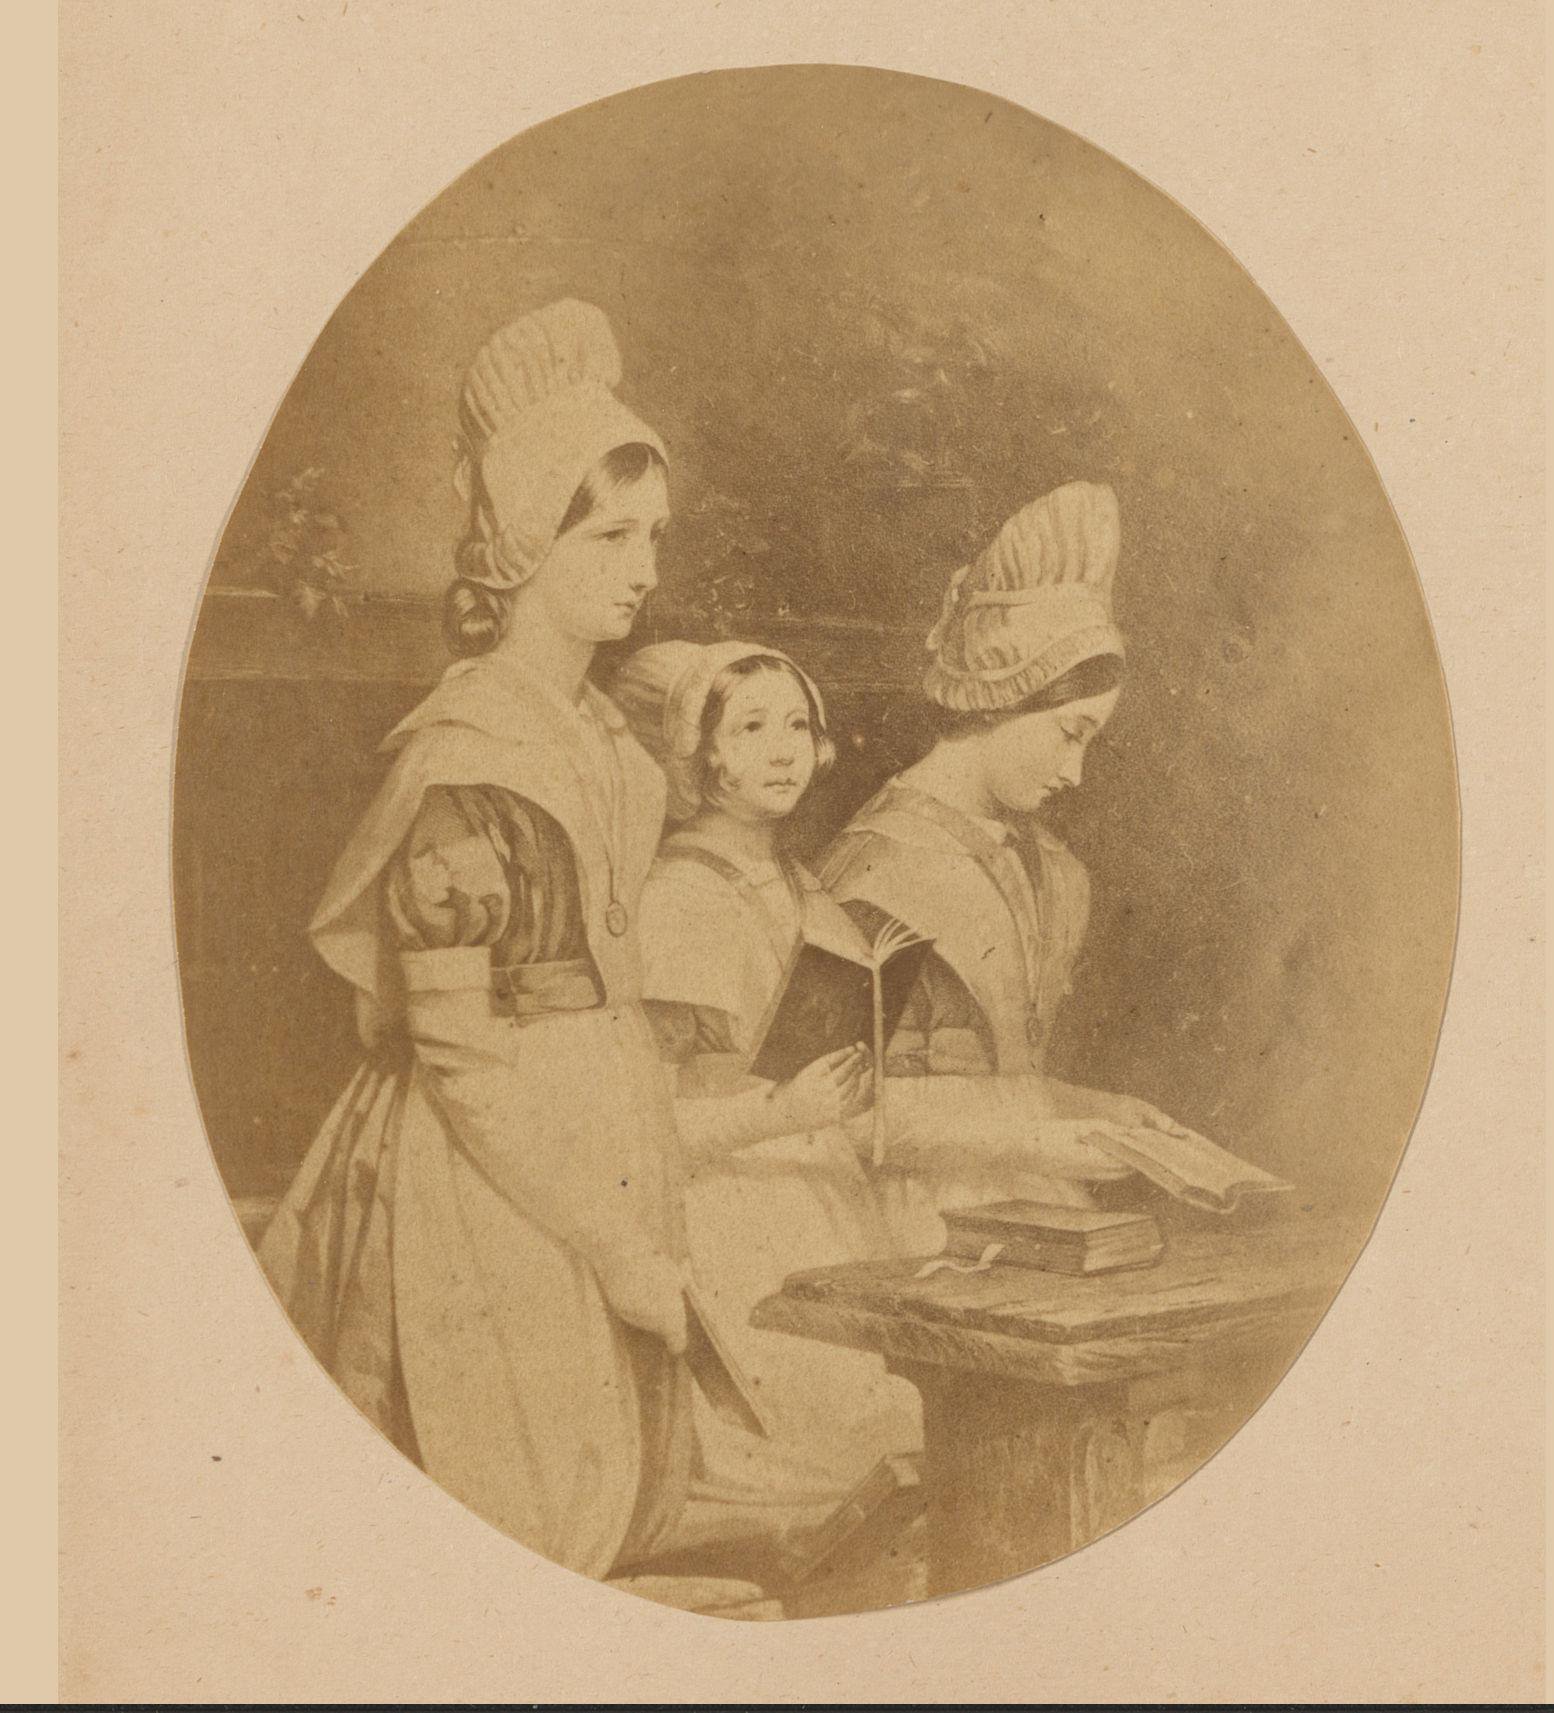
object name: reproduction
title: Fotoreproductie van een schilderij met drie dienstmeisjes die de bijbel lezen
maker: Anonymous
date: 1875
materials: paper, photographic support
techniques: albumen print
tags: reading the bible or other religious books, maid ~ house personnel